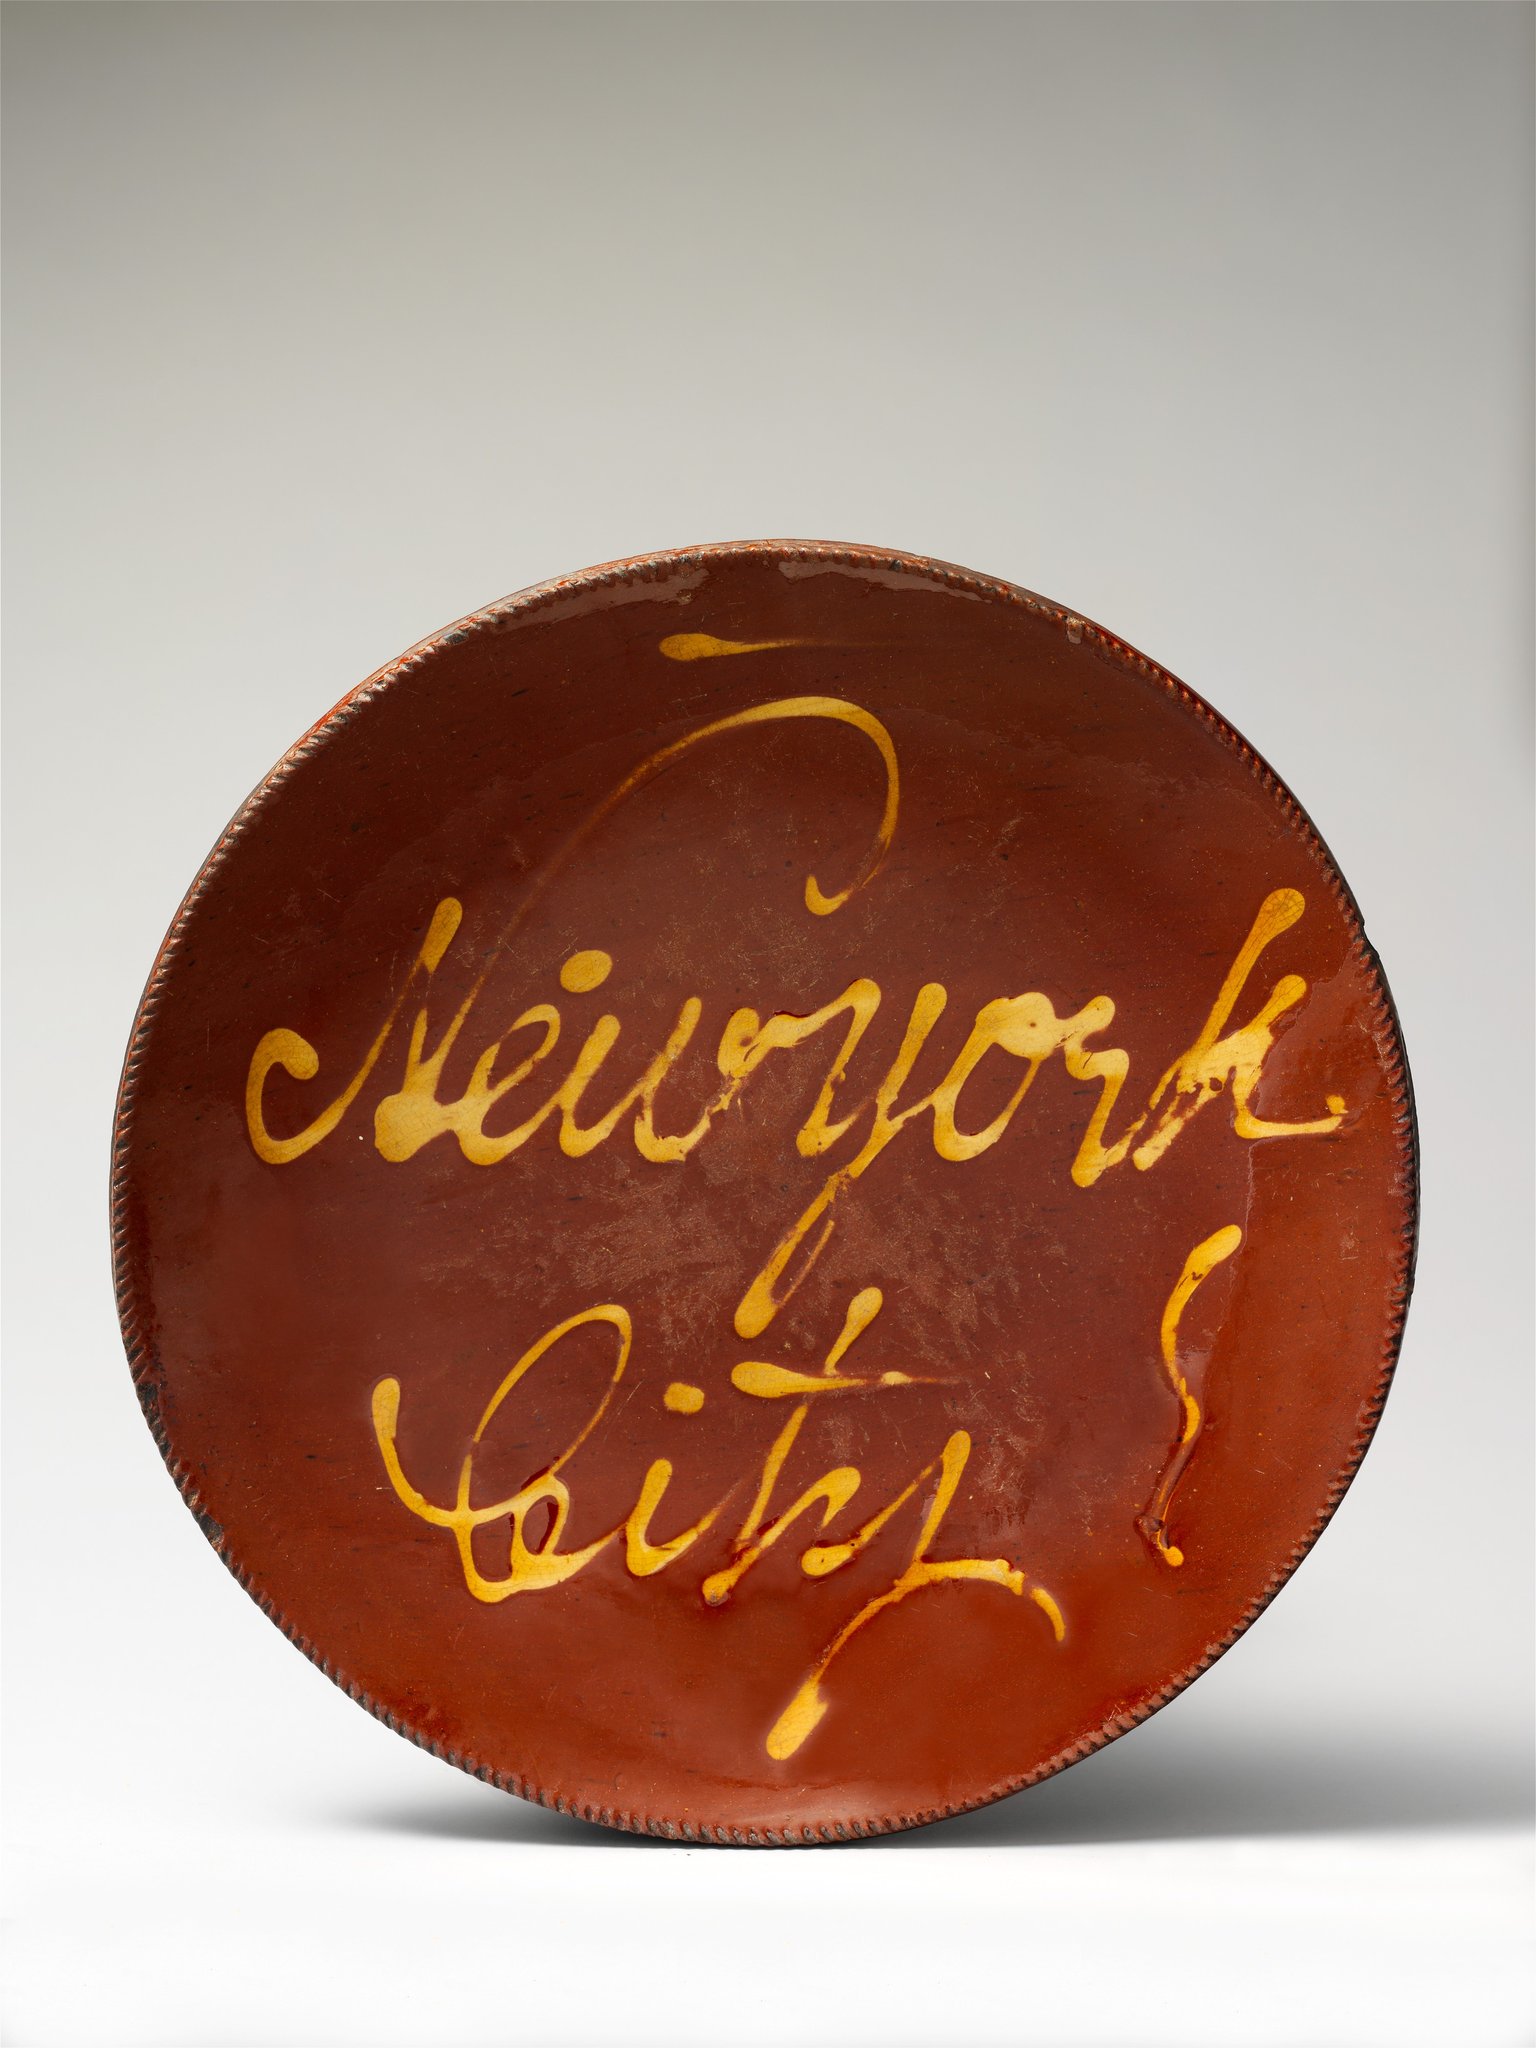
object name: plate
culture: american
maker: asa edward smith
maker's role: maker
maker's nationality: american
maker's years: 1798-1880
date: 1825-1850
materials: earthenware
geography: united states